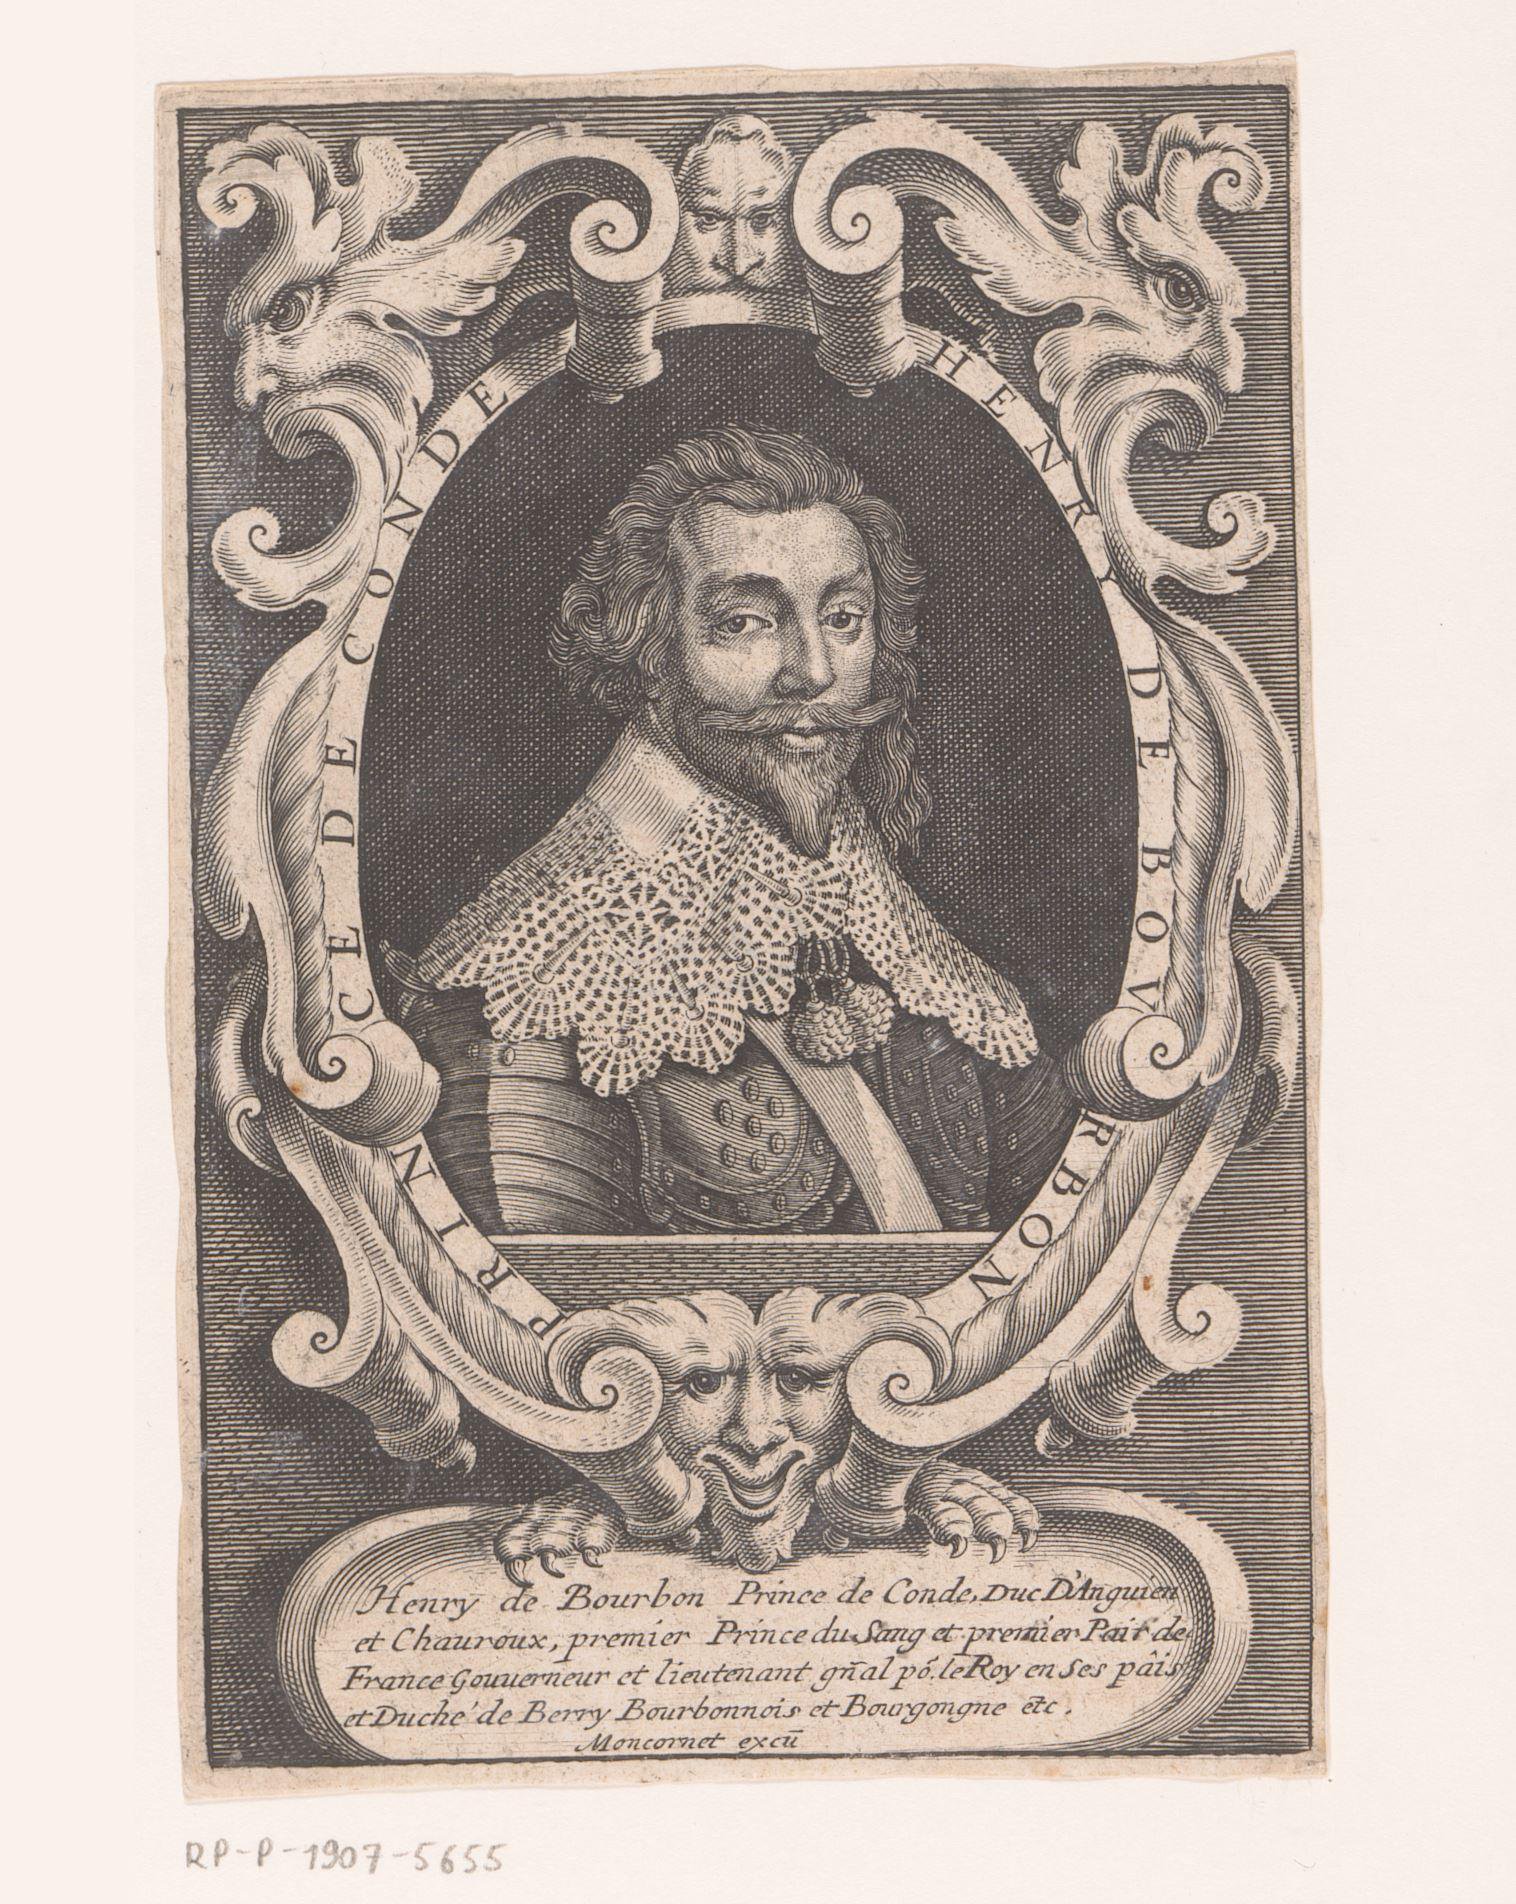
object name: print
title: Portret van Hendrik II van Bourbon-Condé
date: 1610-1668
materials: paper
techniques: engraving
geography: paris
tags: paris, henri (prince of condé), prince, historical persons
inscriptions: collector's mark: Lugt 2228